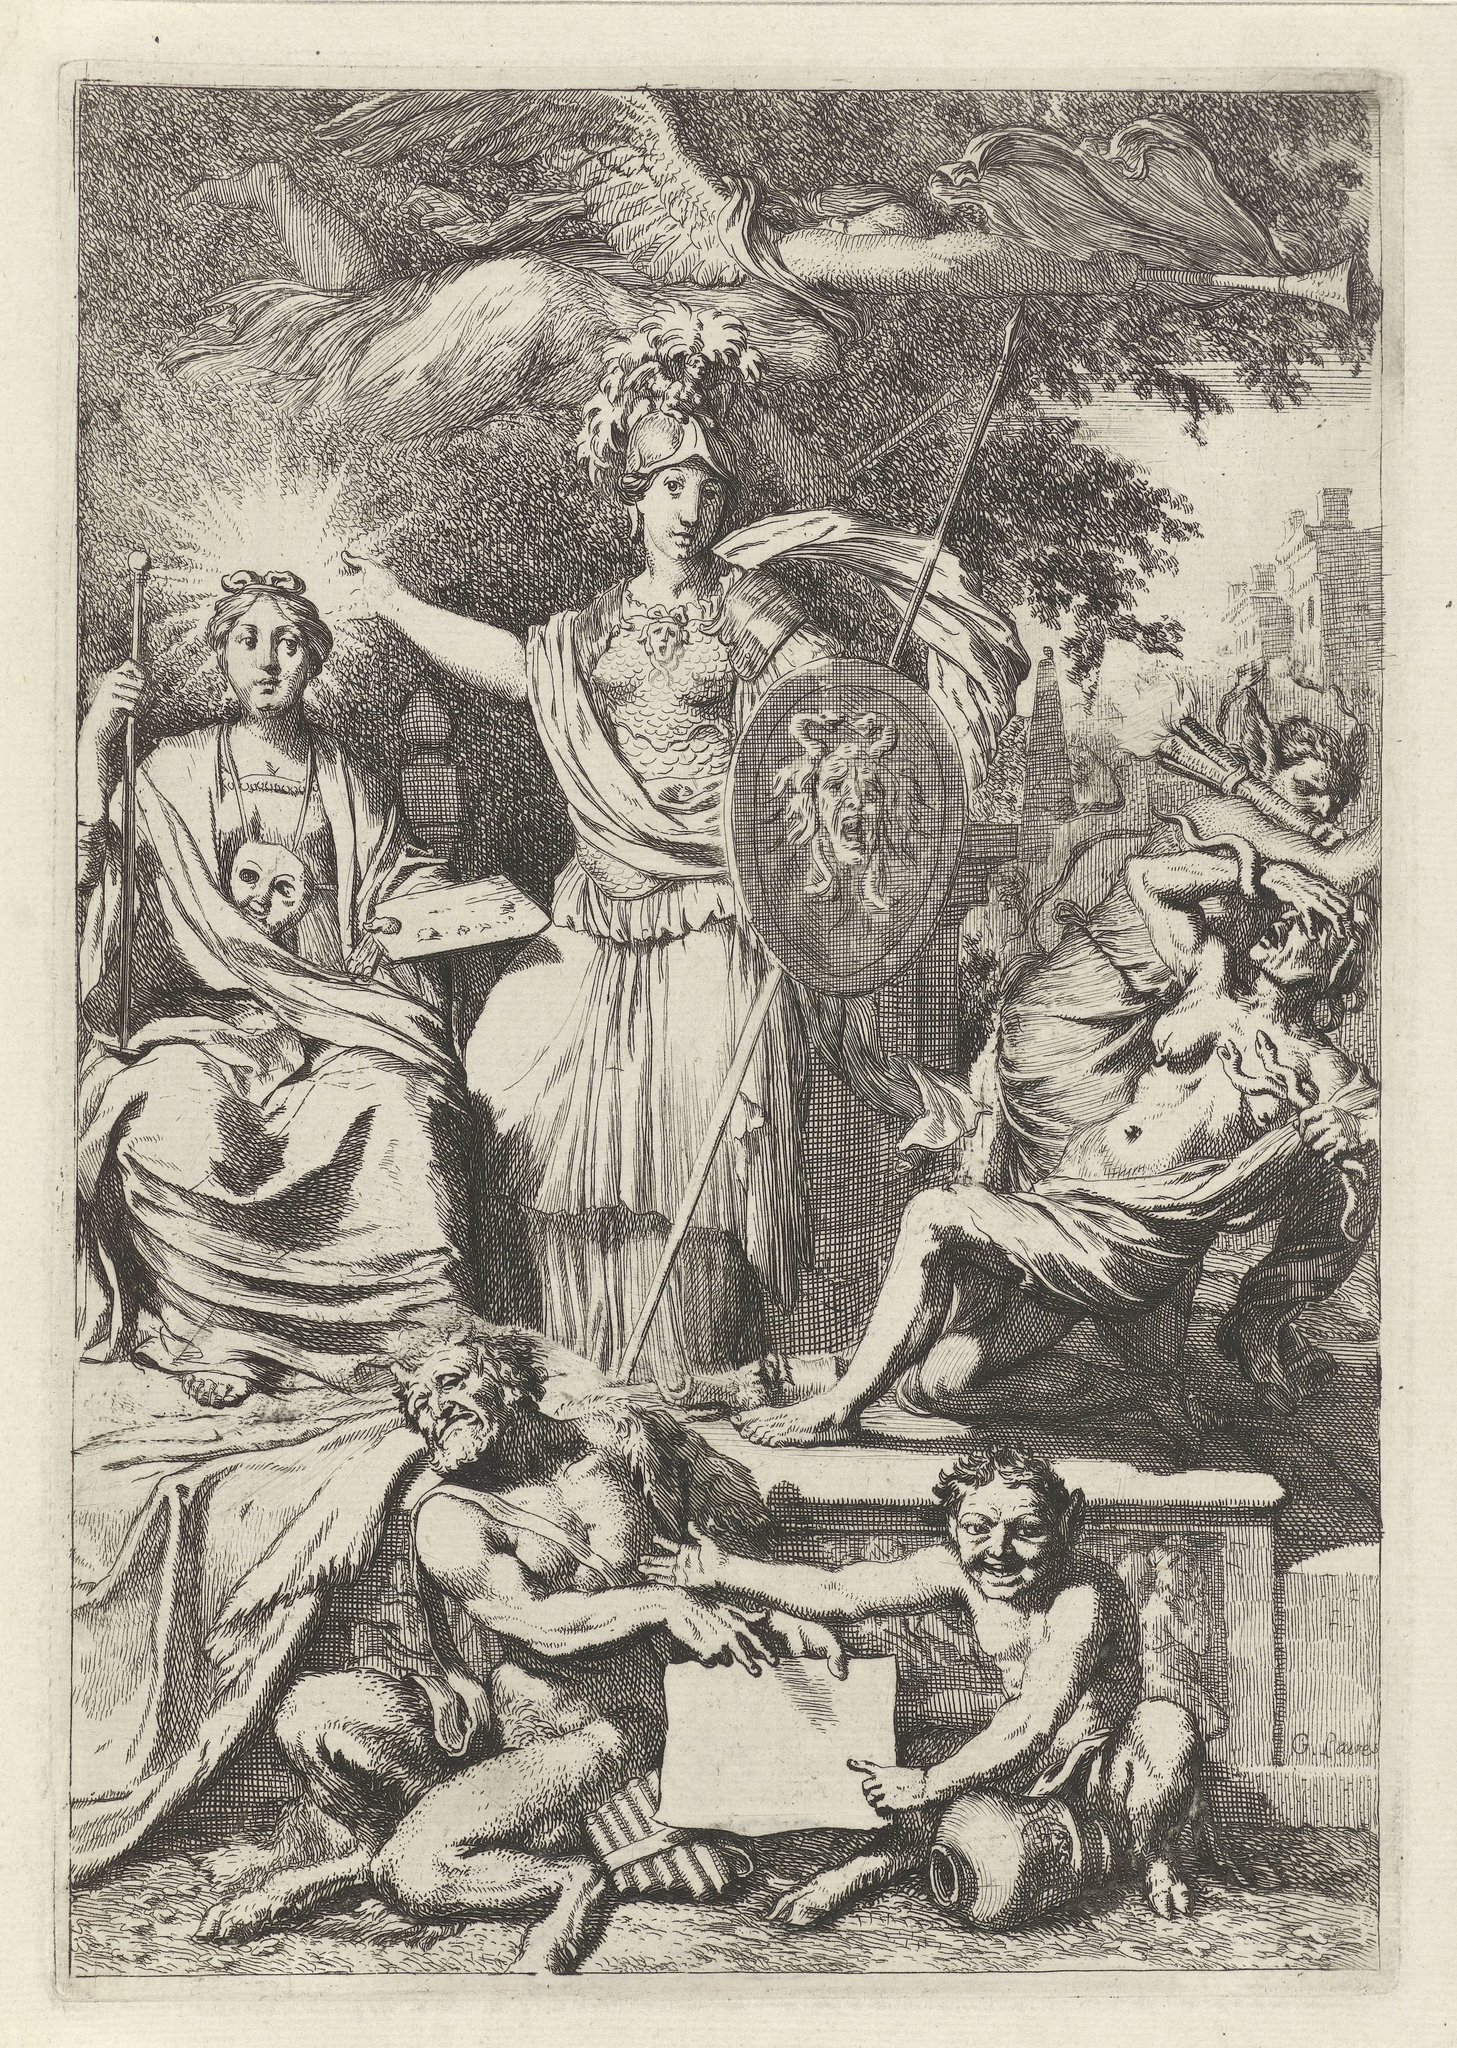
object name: print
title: Minerva beschermt de Schilderkunst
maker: gerard de lairesse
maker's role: draughtsman, painter, print maker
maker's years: 1641-1711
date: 1675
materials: paper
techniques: etching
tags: fury; 'furore', 'furore implacabile', 'furore & rabbia', 'furore superbo & indomito' (ripa), 'pictura', symbolic representations, allegories and emblems ~ painting; 'pittura' (ripa), envy; 'invidia' (ripa) ~ personification of one of the seven deadly sins, (story of) minerva (pallas, athena), satyr(s) (in general), fame; 'fama', 'fama buona', 'fama chiara' (ripa)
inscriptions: collector's mark: Lugt 2228, collector's mark: Lugt 237 a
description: Minerva beschermt de gepersonifieerde schilderkunst (masker en schilderspalet) tegen de Afgunst (slangen) en Razernij (brandende toorts). Boven Minerva vliegt de bazuin blazende Faam. Op de voorgrond houden een jonge en oude sater samen een stuk papier vast.